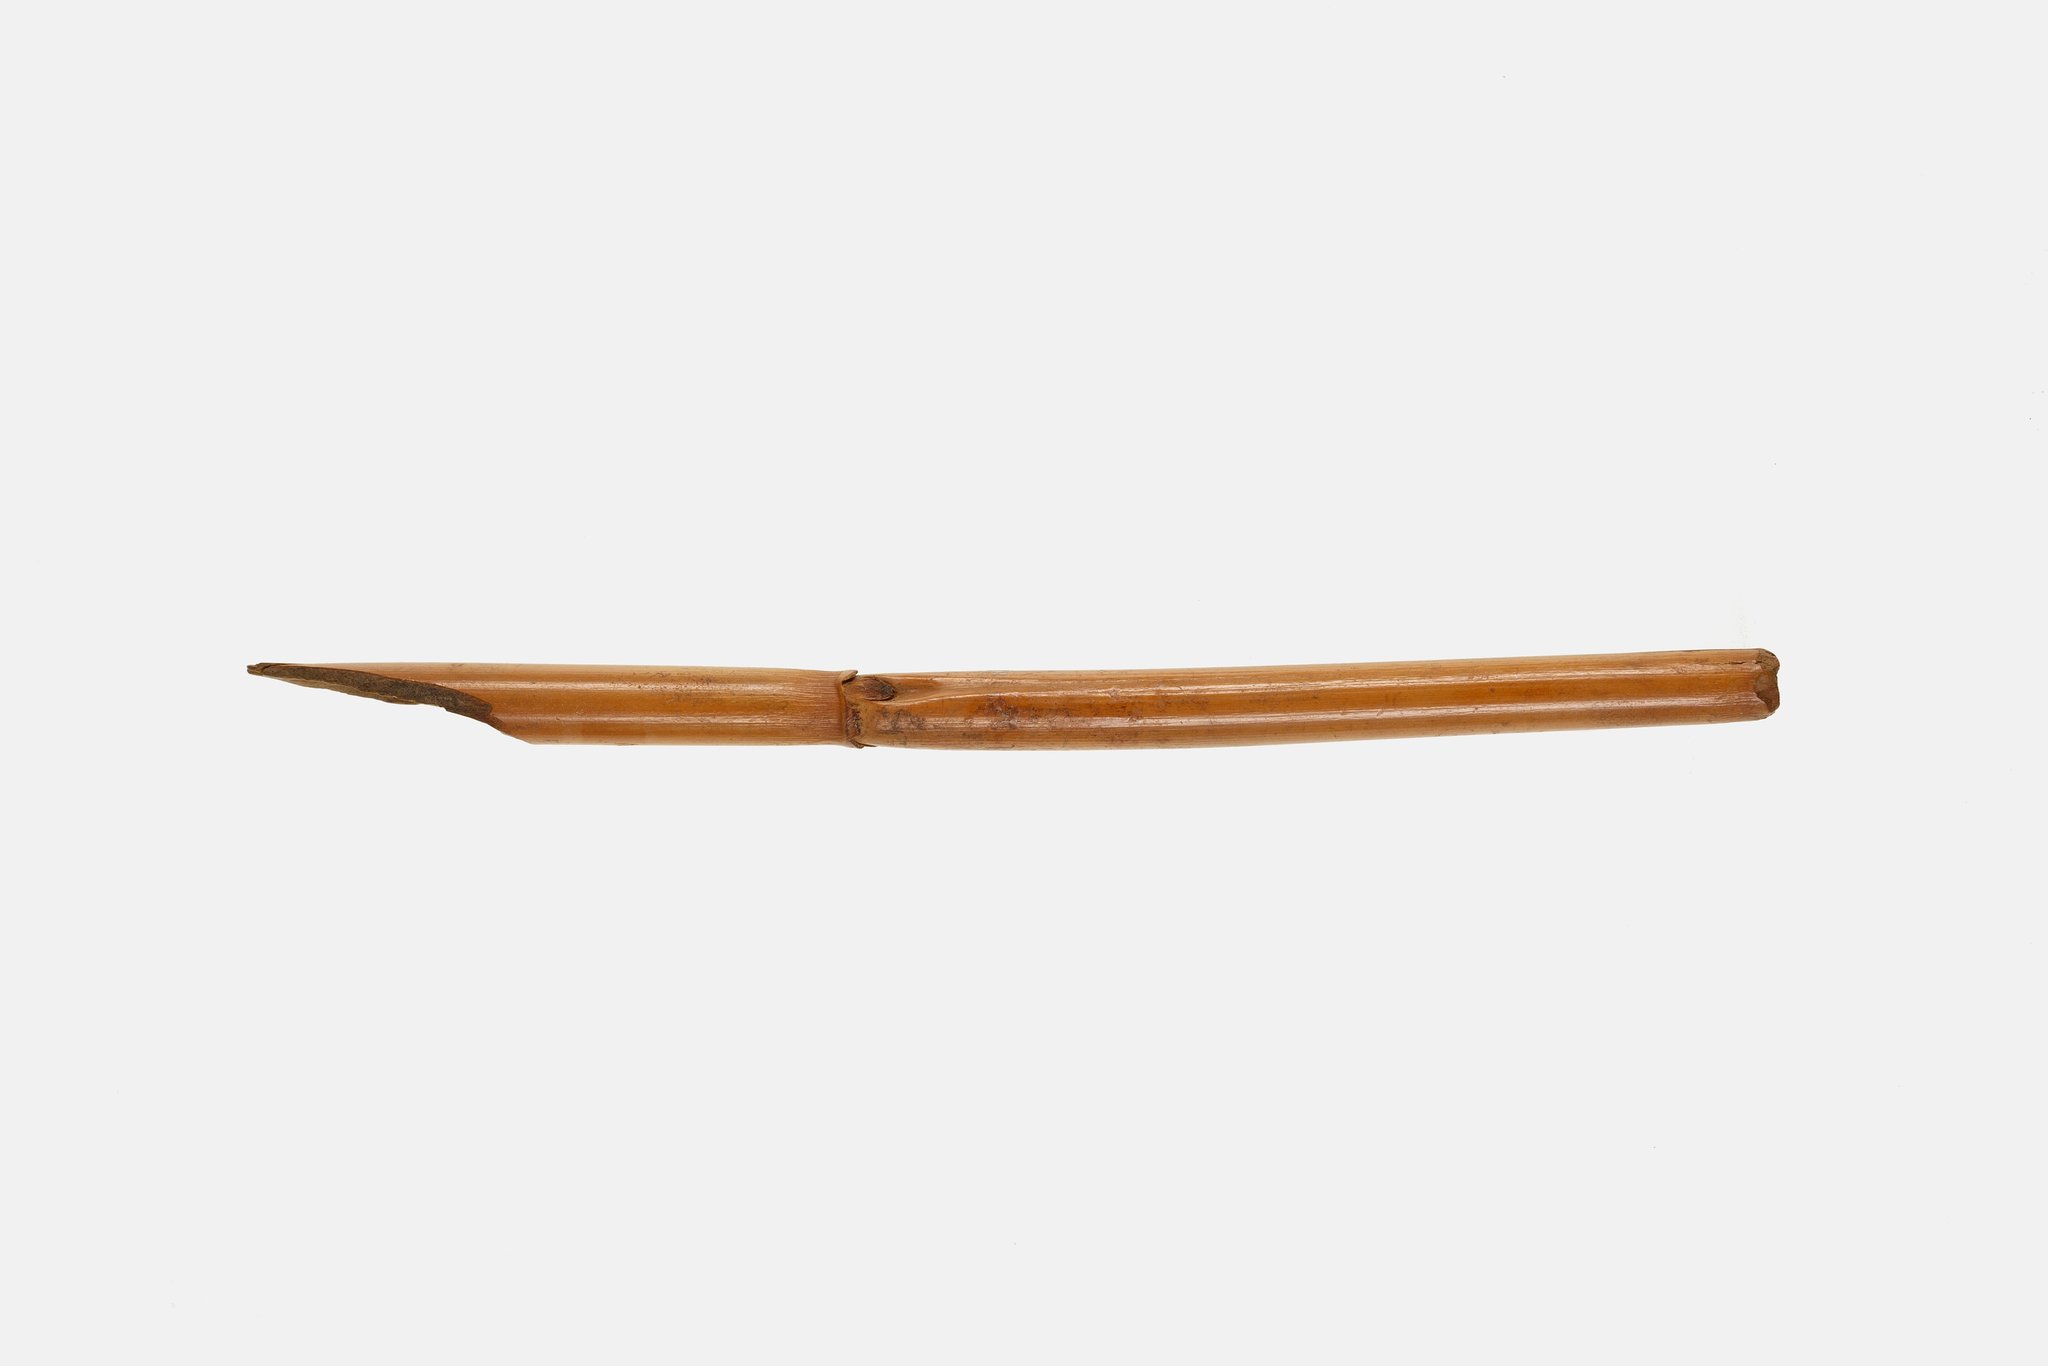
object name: pen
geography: egypt